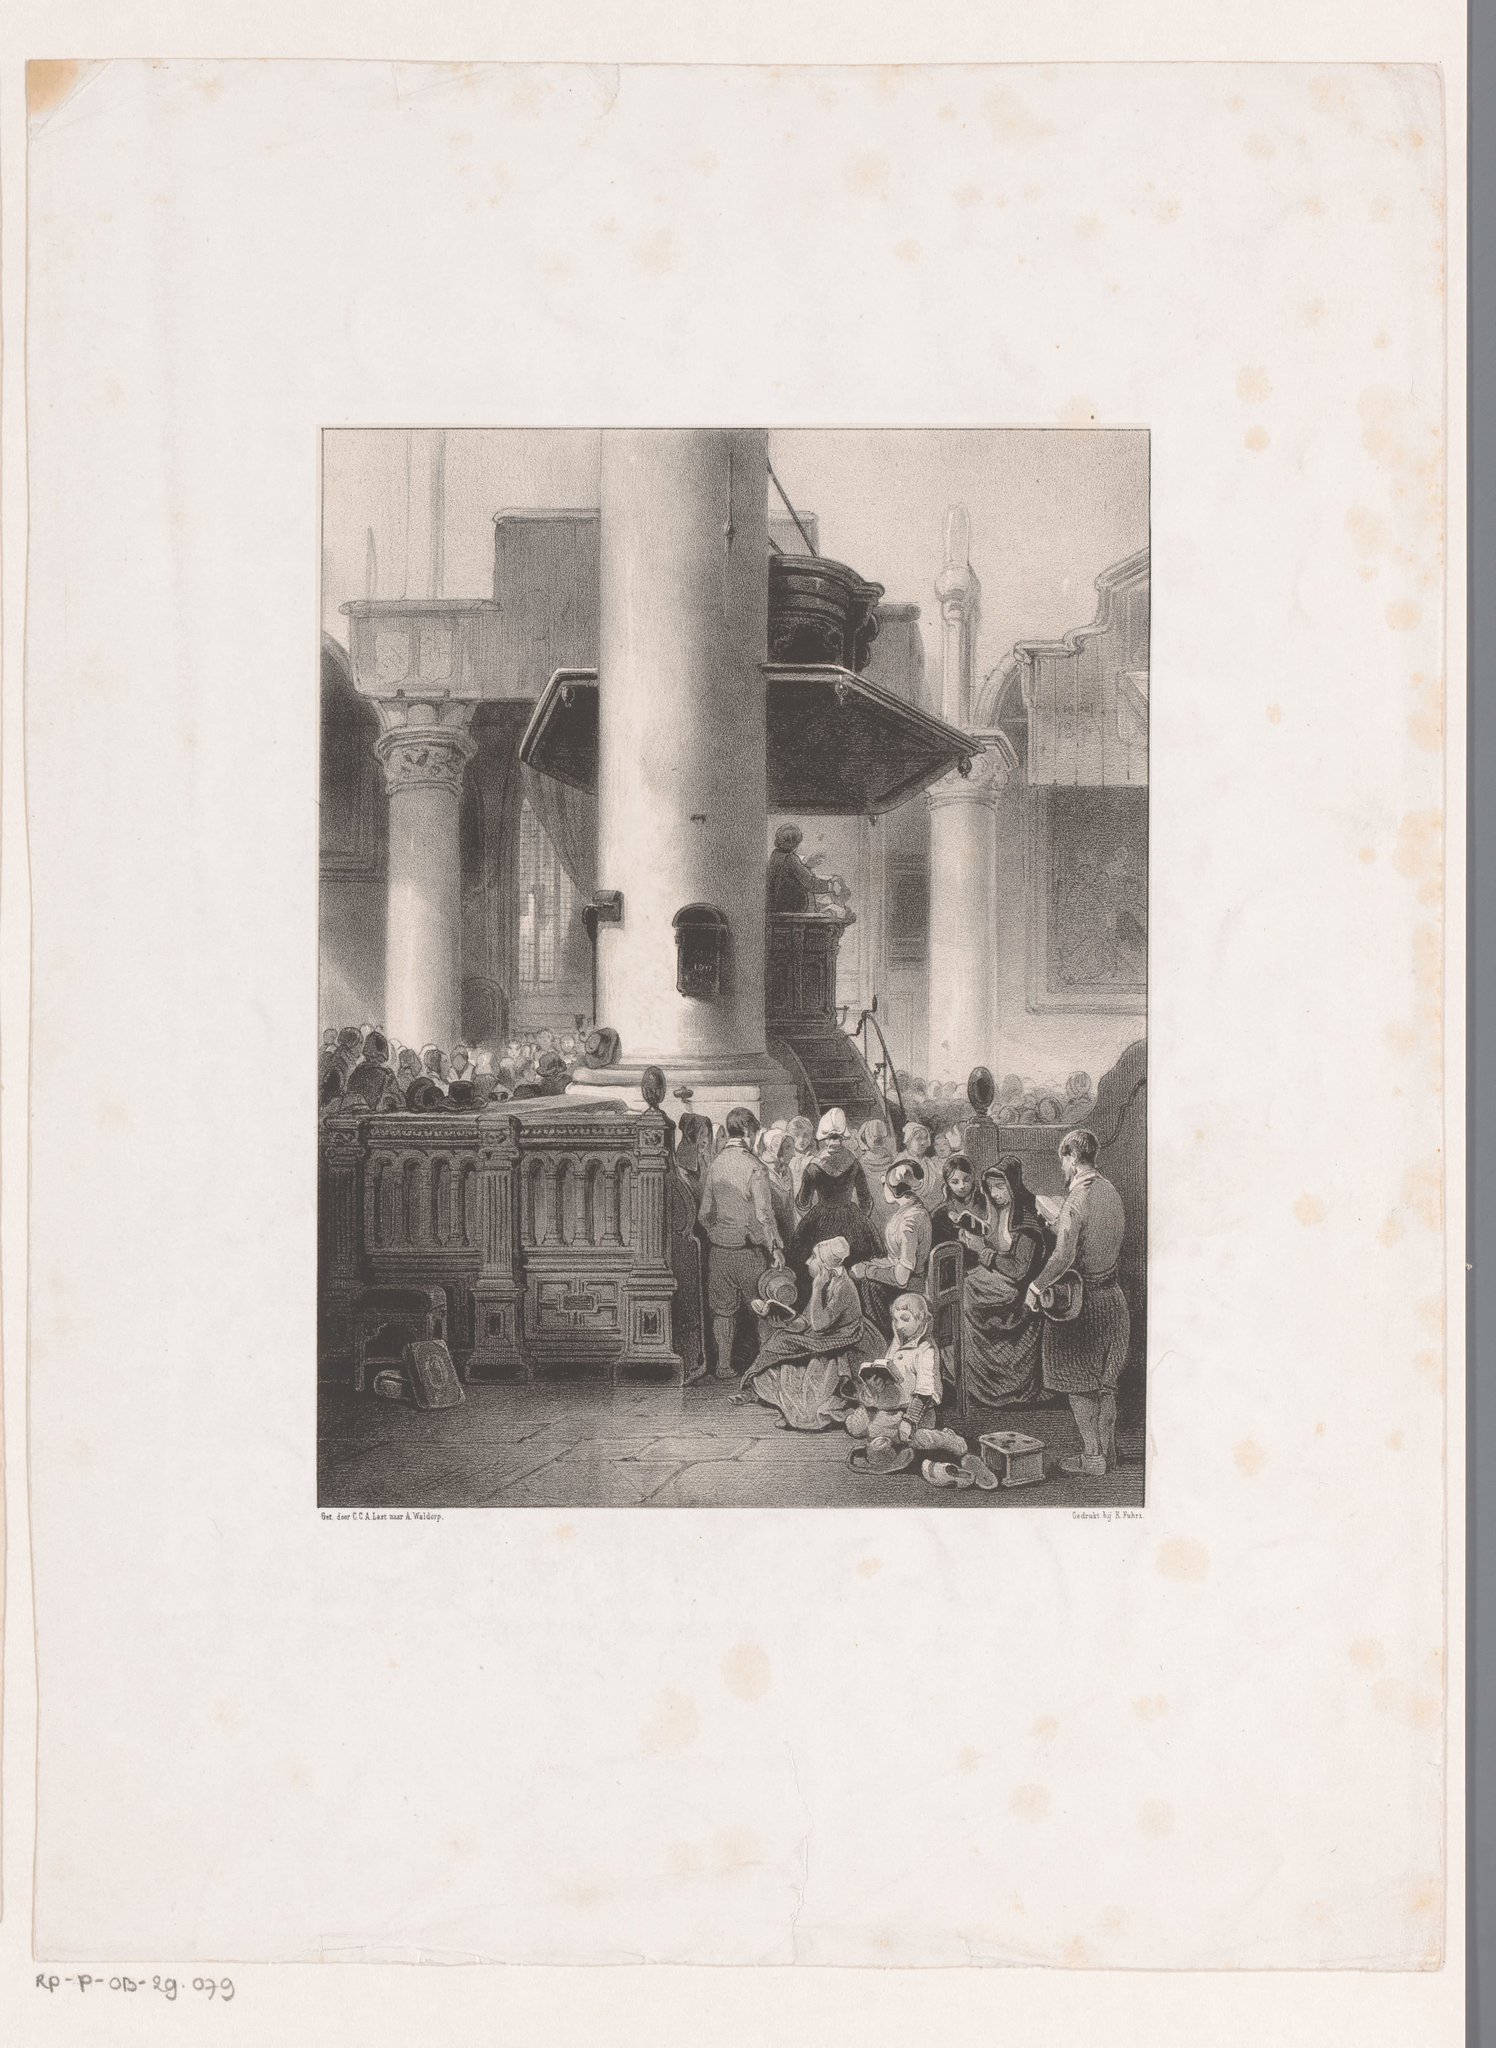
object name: print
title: Kerkdienst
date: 1837-1853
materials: paper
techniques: lithograph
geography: the hague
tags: interior of church, pulpit, ambo, chancel, sermon ~ holy mass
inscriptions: collector's mark: Lugt 2228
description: Een geestelijke spreekt de gemeenschap toe die zich rondom de kansel heeft verzameld.